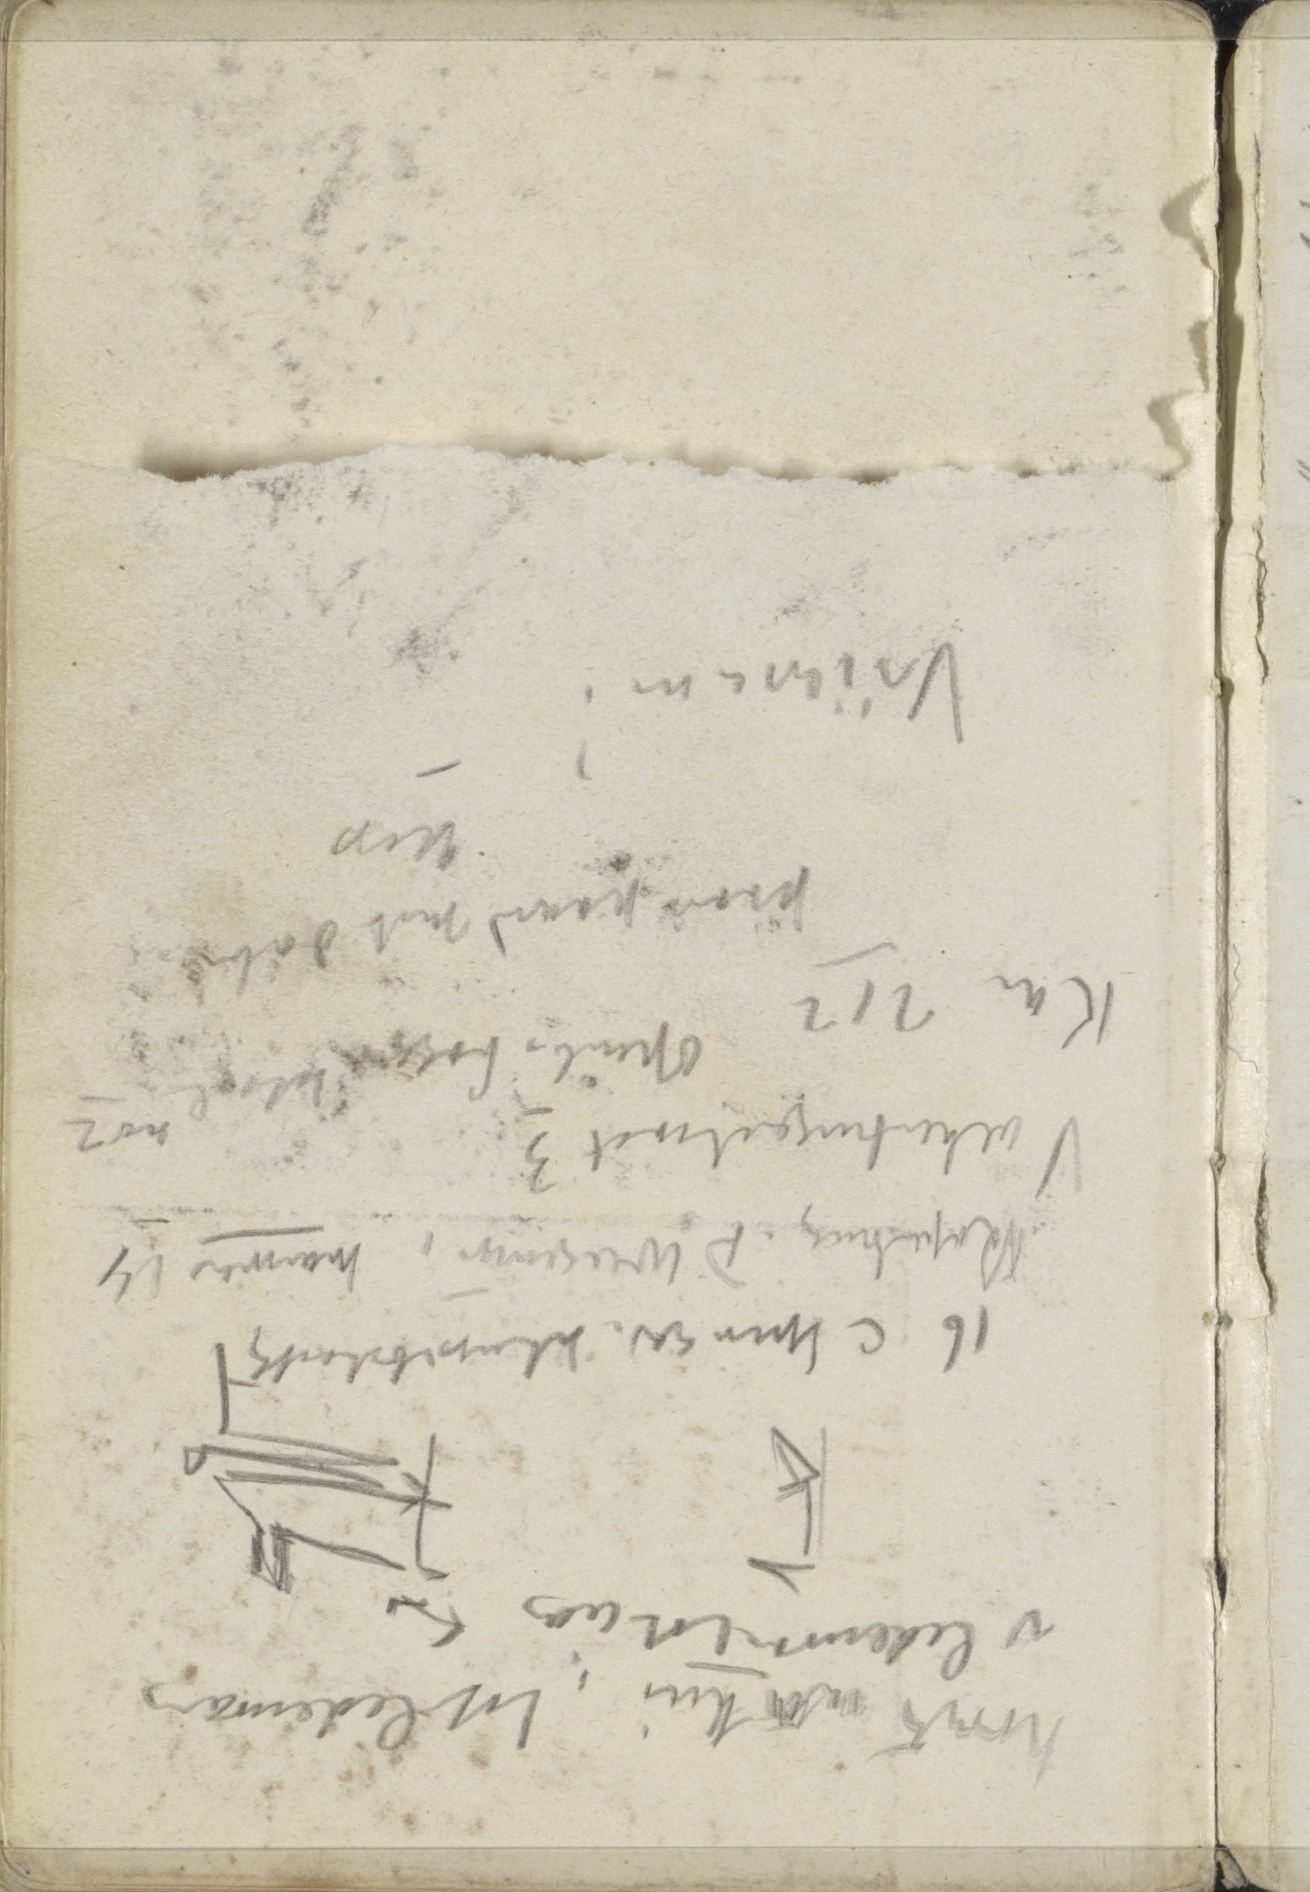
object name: sketchbook leaf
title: Studies en annotaties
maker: george hendrik breitner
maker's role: draughtsman, painter, print maker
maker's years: 1857-1923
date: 1910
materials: chalk, paper, pencil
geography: amsterdam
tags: roof (of house or building)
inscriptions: annotation: ‘[...]’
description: Studies, waaronder mogelijk een studie van een dak. Pagina 91 uit een schetsboek met 45 bladen.